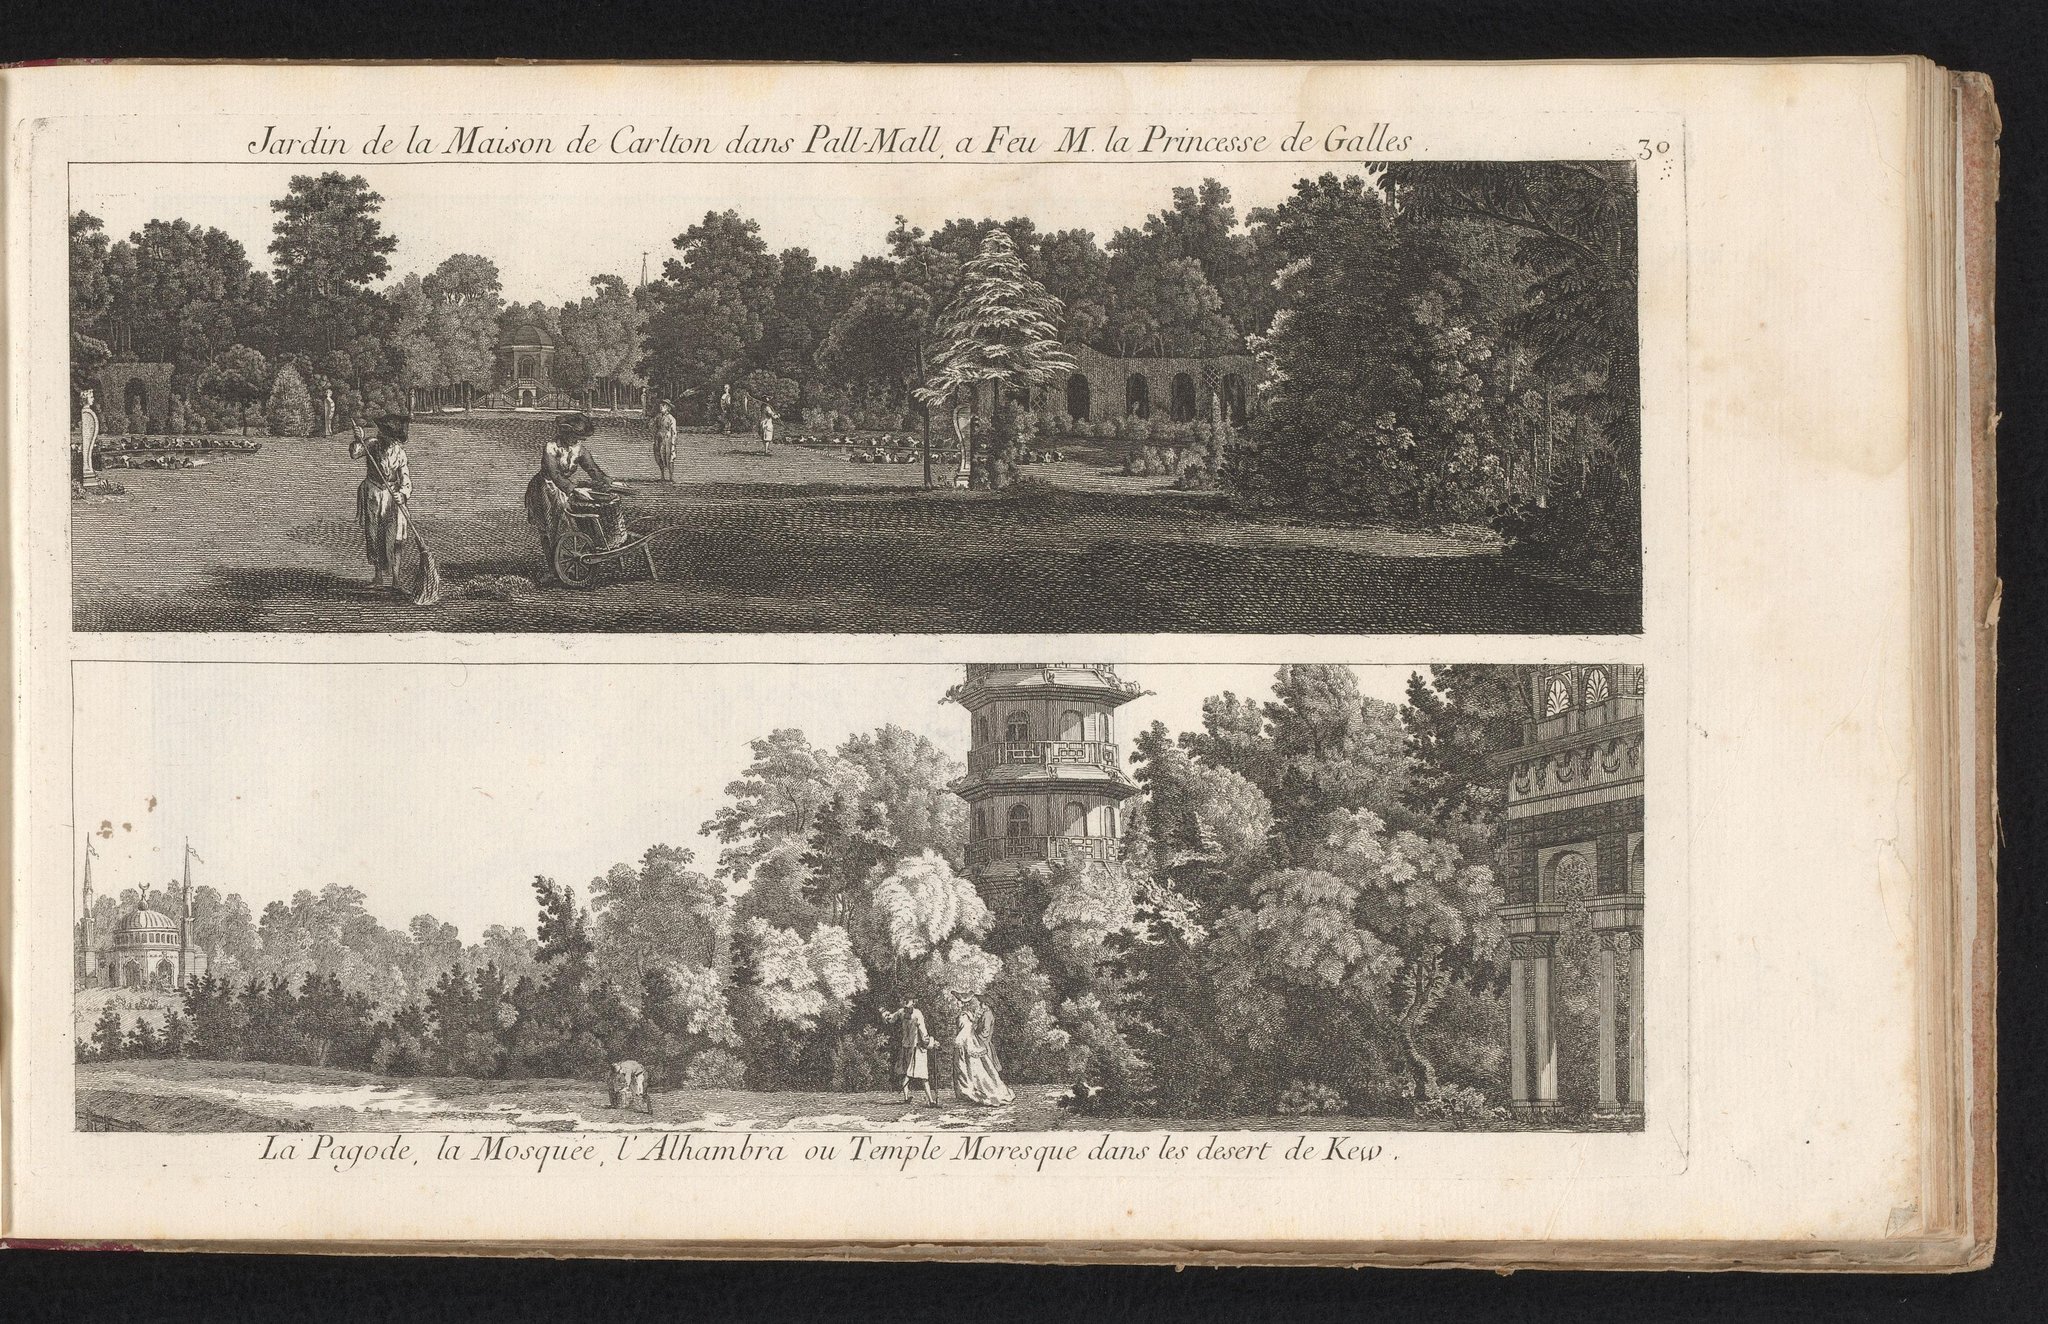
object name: album leaf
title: Jardin de la Maison de Carlton dans Pall-Mall, a feu m. la Princesse de Galles/ La pagode, la mosquée, l'Alhambra ou temple moresque dans les desert de Kew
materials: paper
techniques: engraving, etching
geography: paris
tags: lay-out of garden, garden buildings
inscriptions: collector's mark: Lugt 2228, collector's mark: Lugt 2760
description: De serie 'Jardins anglo-chinois à la mode' verscheen in totaal in 21 zogeheten 'cahiers' (afleveringen). De huidige prent komt uit het zesde 'cahier'. Het Rijksmuseum Amsterdam bezit drie banden met daarin in totaal zes 'cahiers' van deze reeks. In de documentatie wordt verwezen naar een in de bibliotheek van het Rijksmuseum Amsterdam aanwezige facsimile van het complete werk.